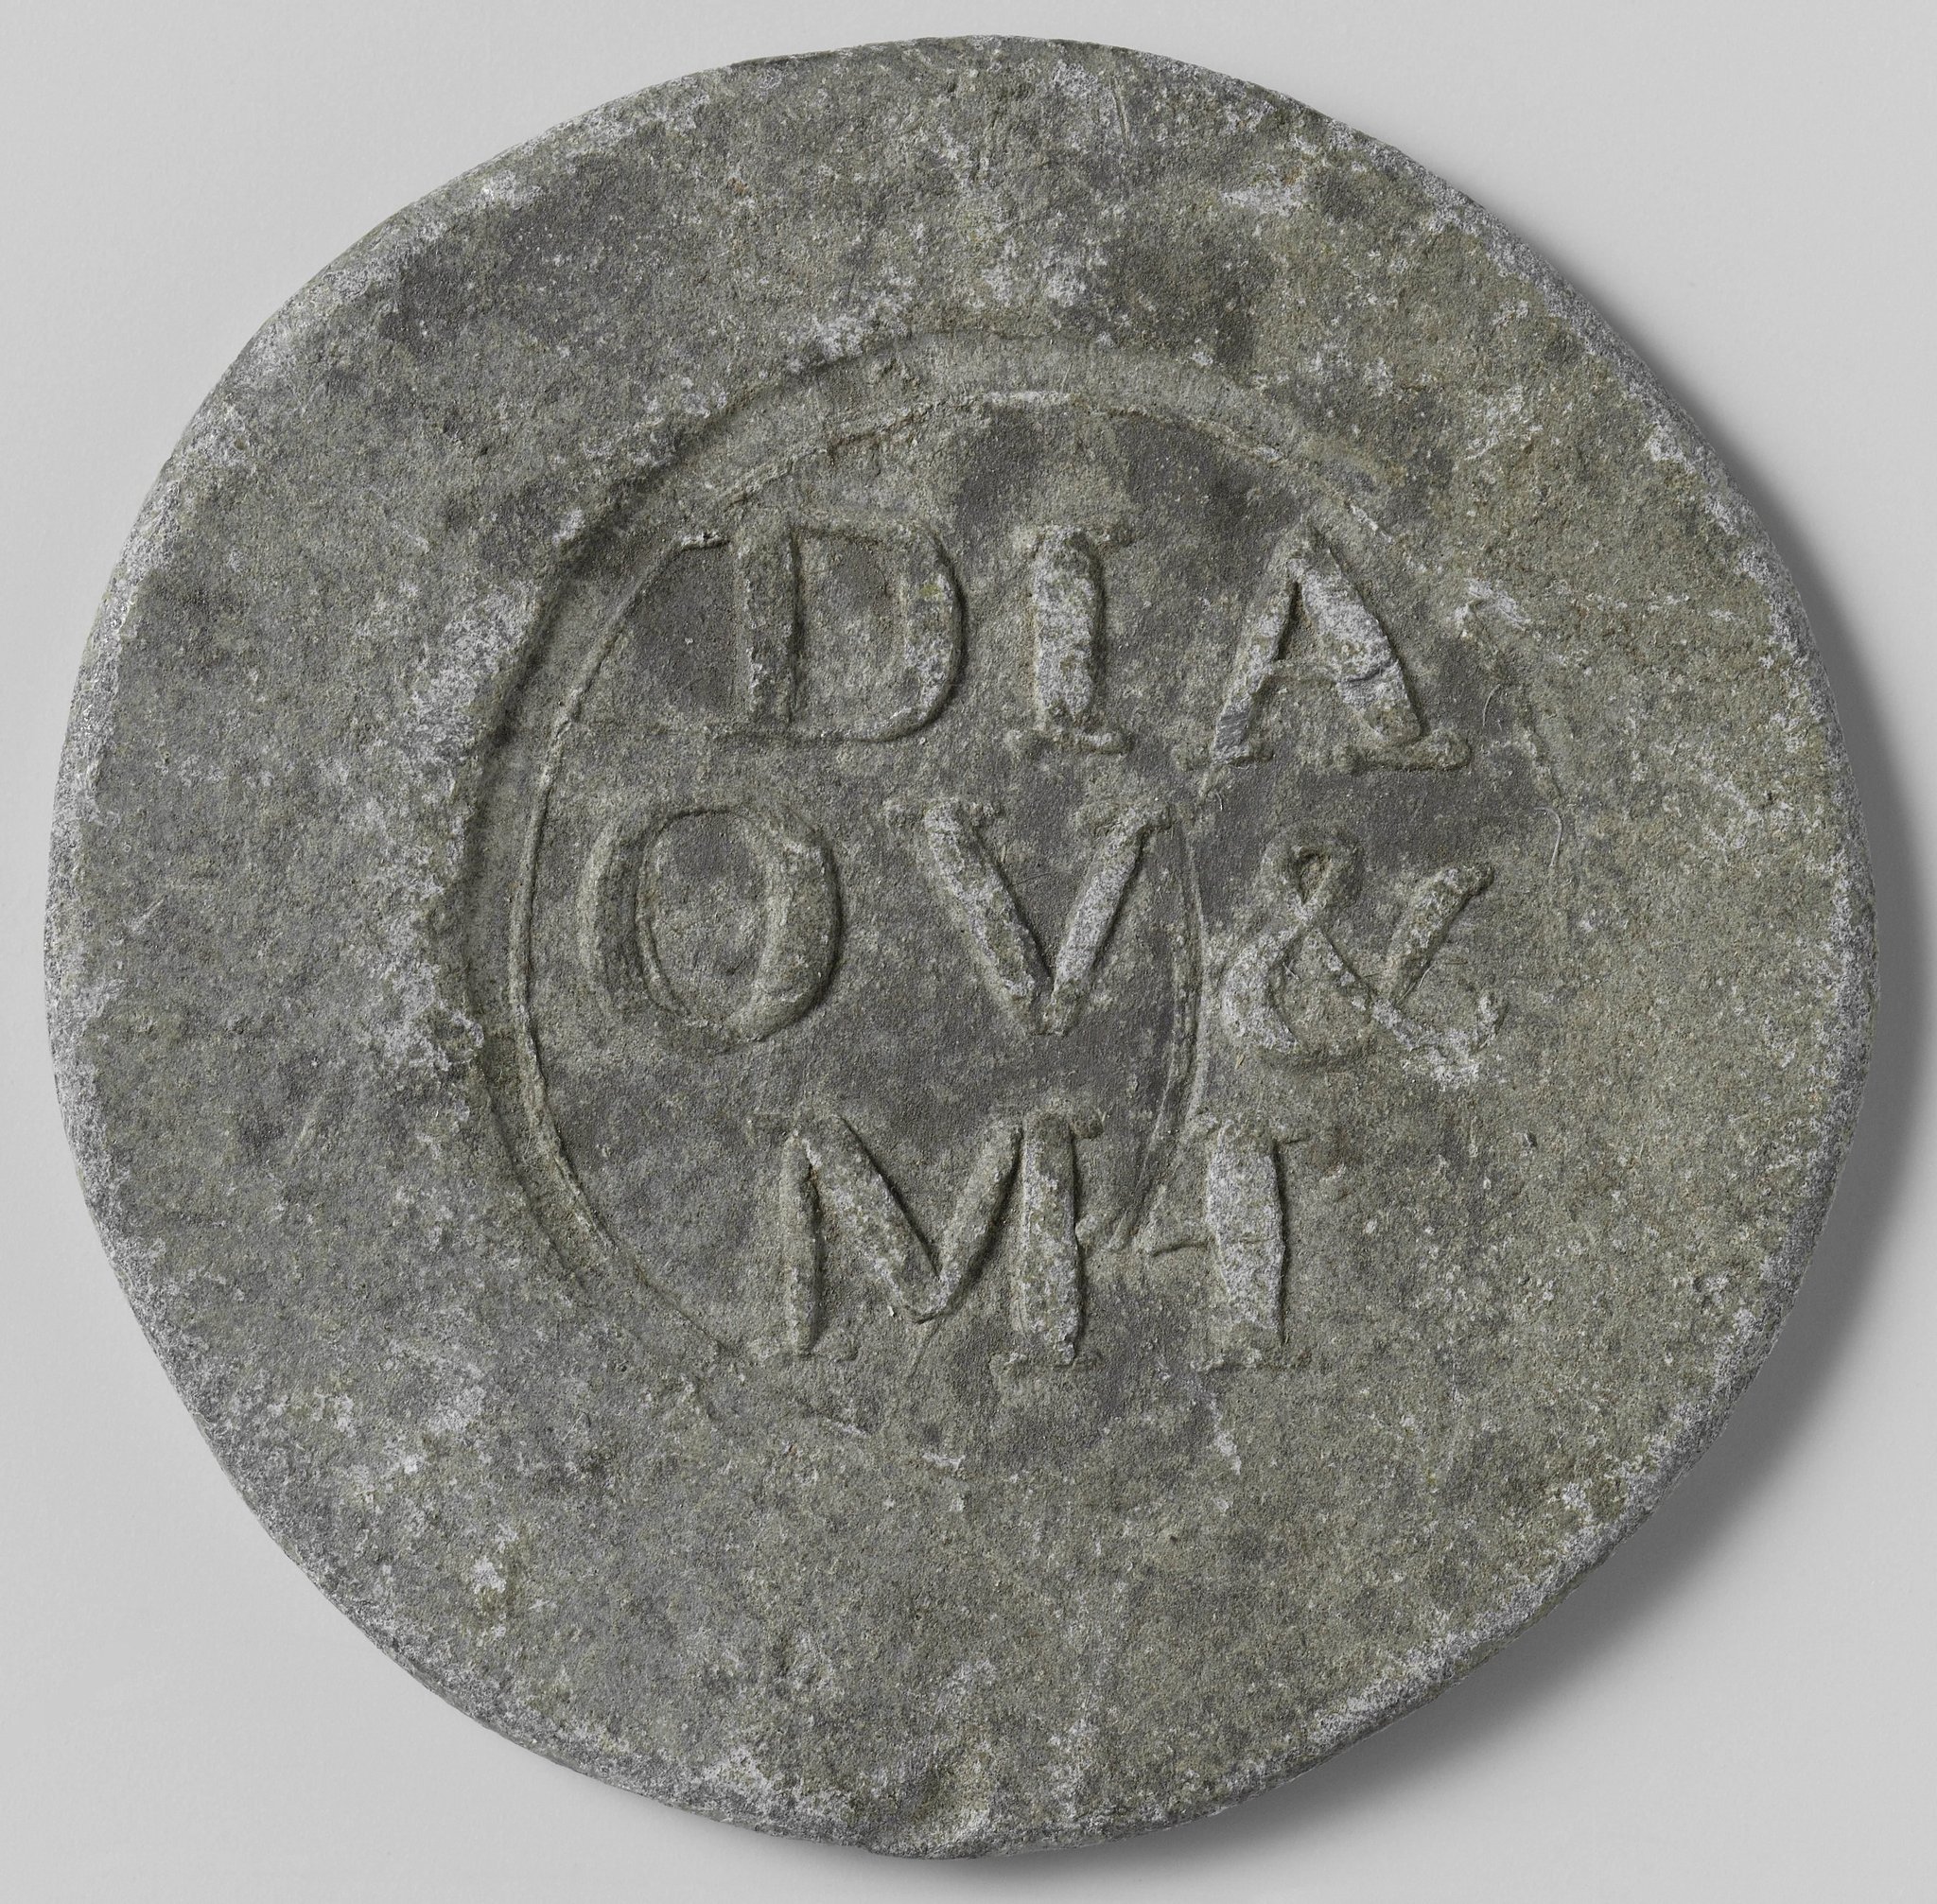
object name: alms token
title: Diaconiehuis voor oude mannen en vrouwen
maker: Anonymous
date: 1600-1800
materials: lead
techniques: casting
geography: amsterdam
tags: amsterdam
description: Eenzijdige loden penning. Voorzijde: opschrift DIA / OV& / MH in cirkel. Keerzijde: blanco.